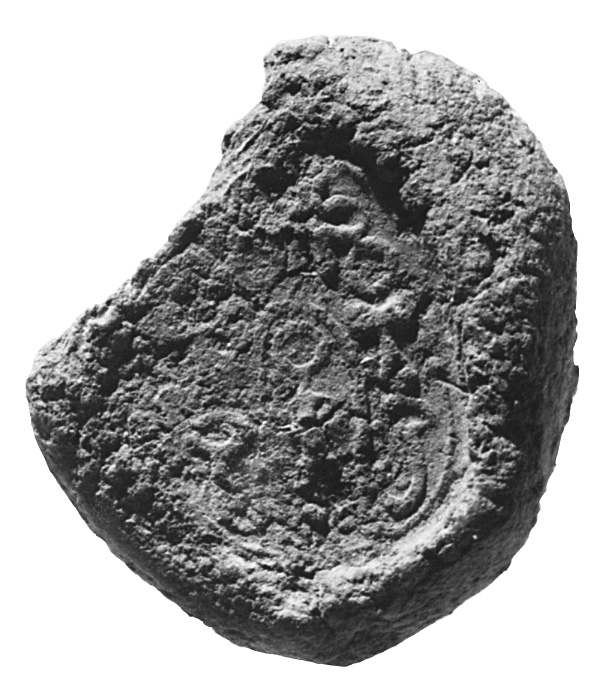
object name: sealing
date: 1981-1640 BCE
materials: mud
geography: egypt